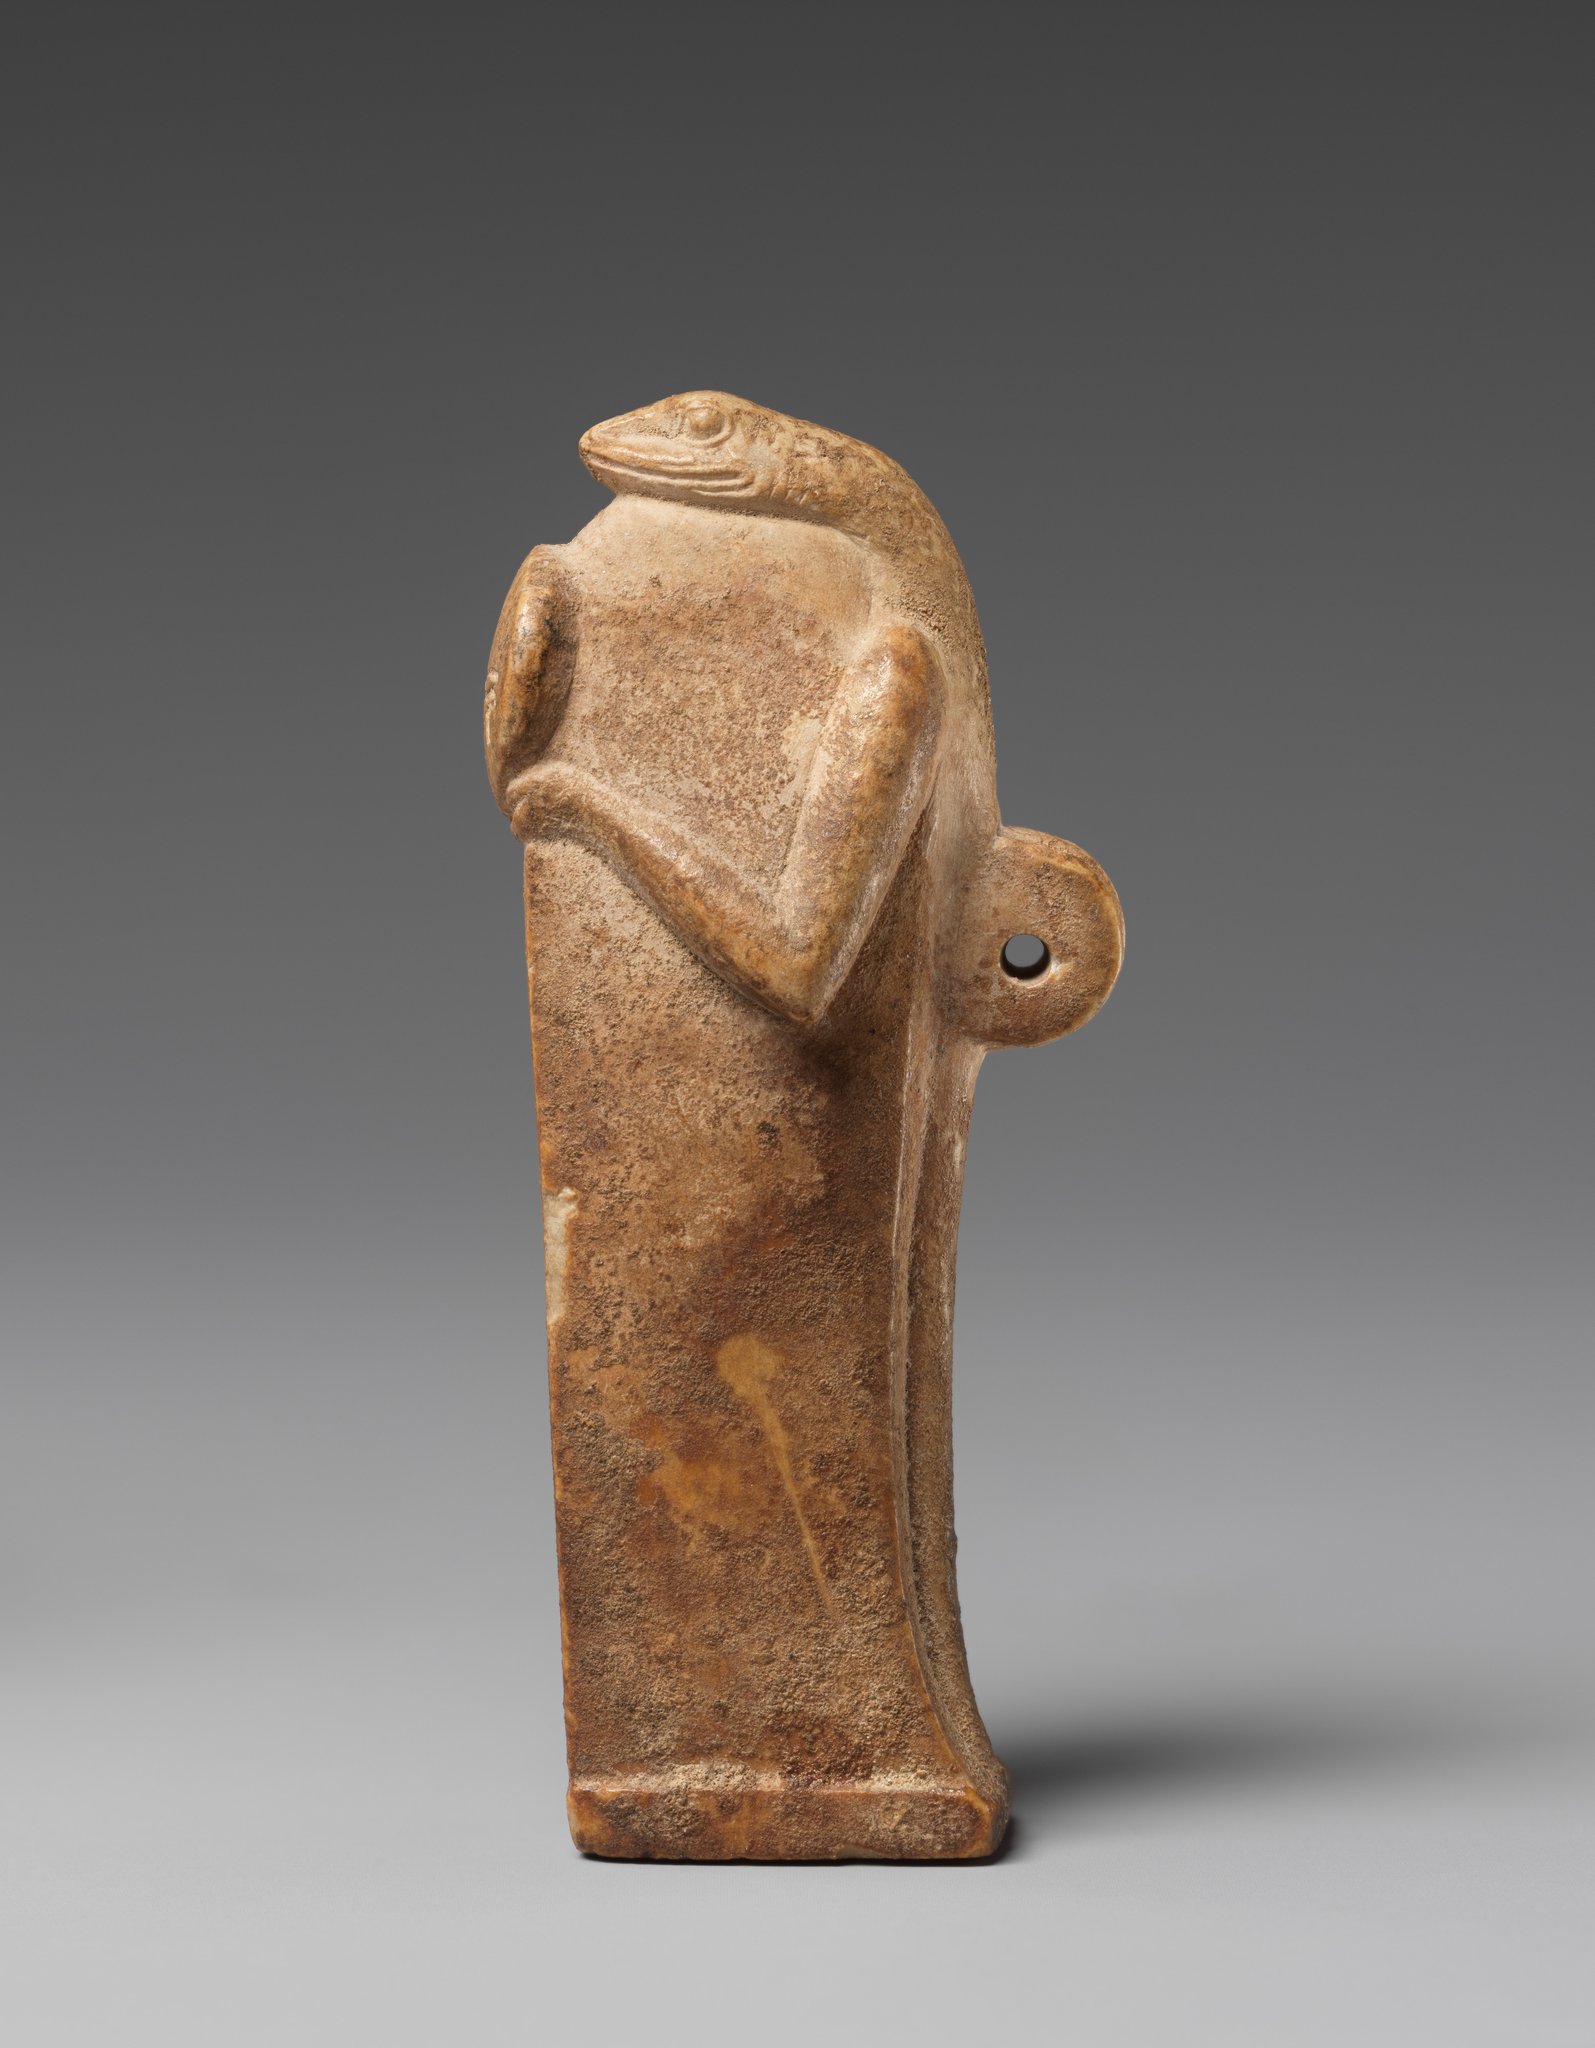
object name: amulet, atum, snake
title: Snake amulet probably representing Atum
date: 664-332 BCE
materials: limestone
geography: egypt